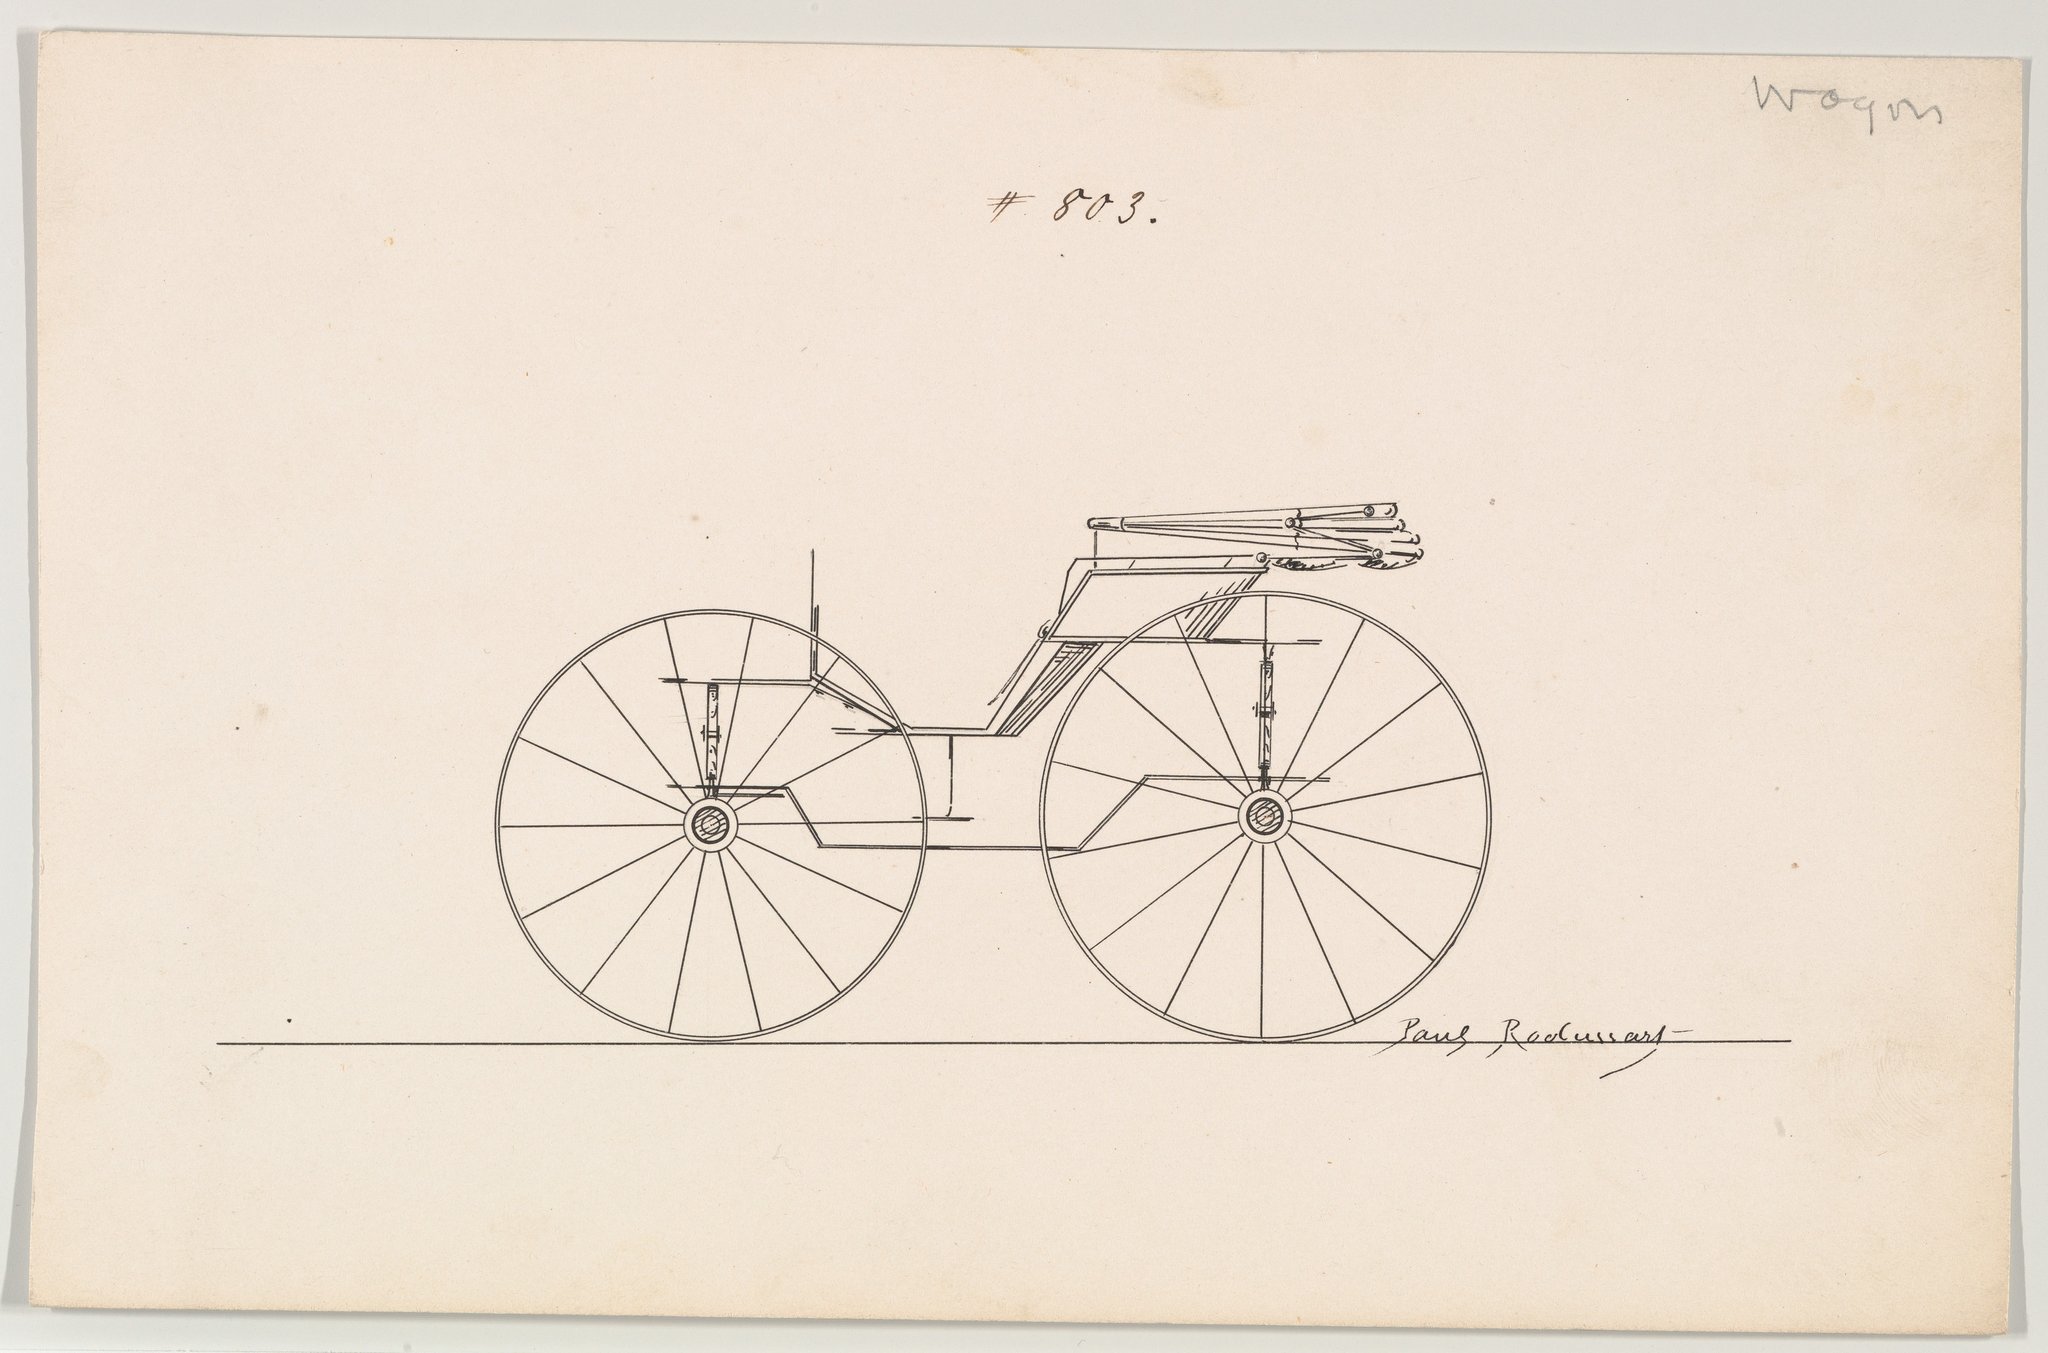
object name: drawing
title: Phaeton #803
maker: brewster & co.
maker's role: manufacturer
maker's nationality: american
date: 1850-1870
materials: ink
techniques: pen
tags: carriages